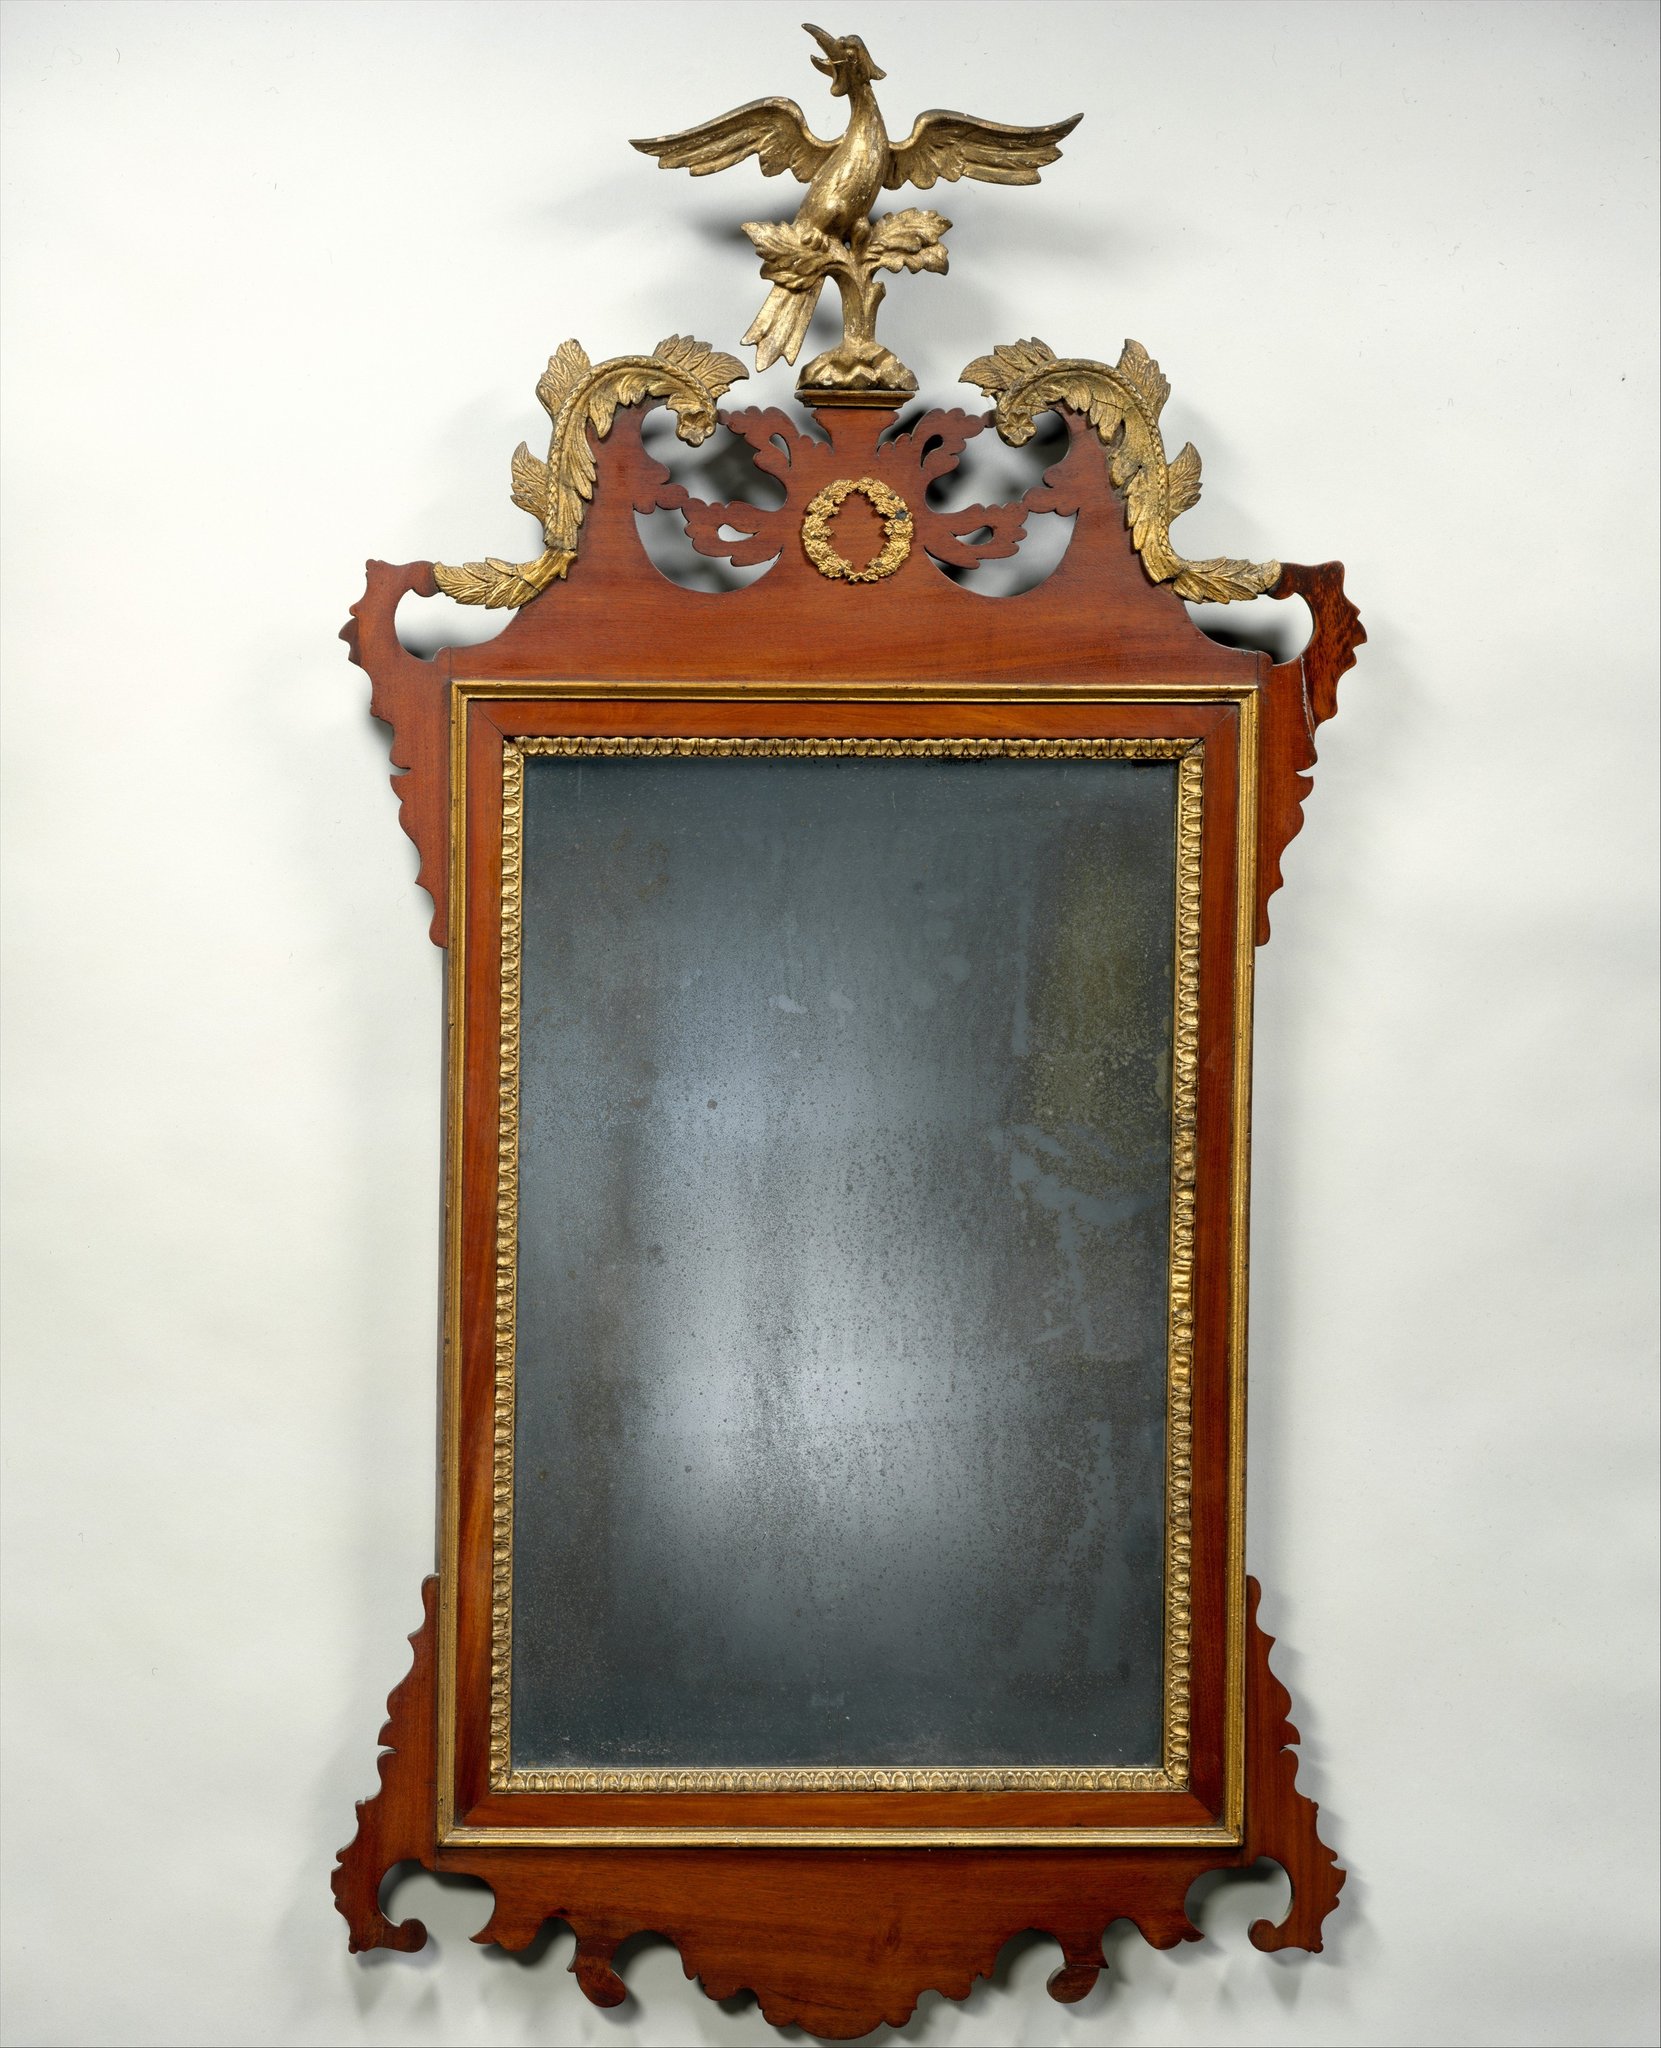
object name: looking glass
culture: american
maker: stephen badlam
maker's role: maker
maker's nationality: american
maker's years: 1751-1815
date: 1780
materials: gilt, wood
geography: united states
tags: birds